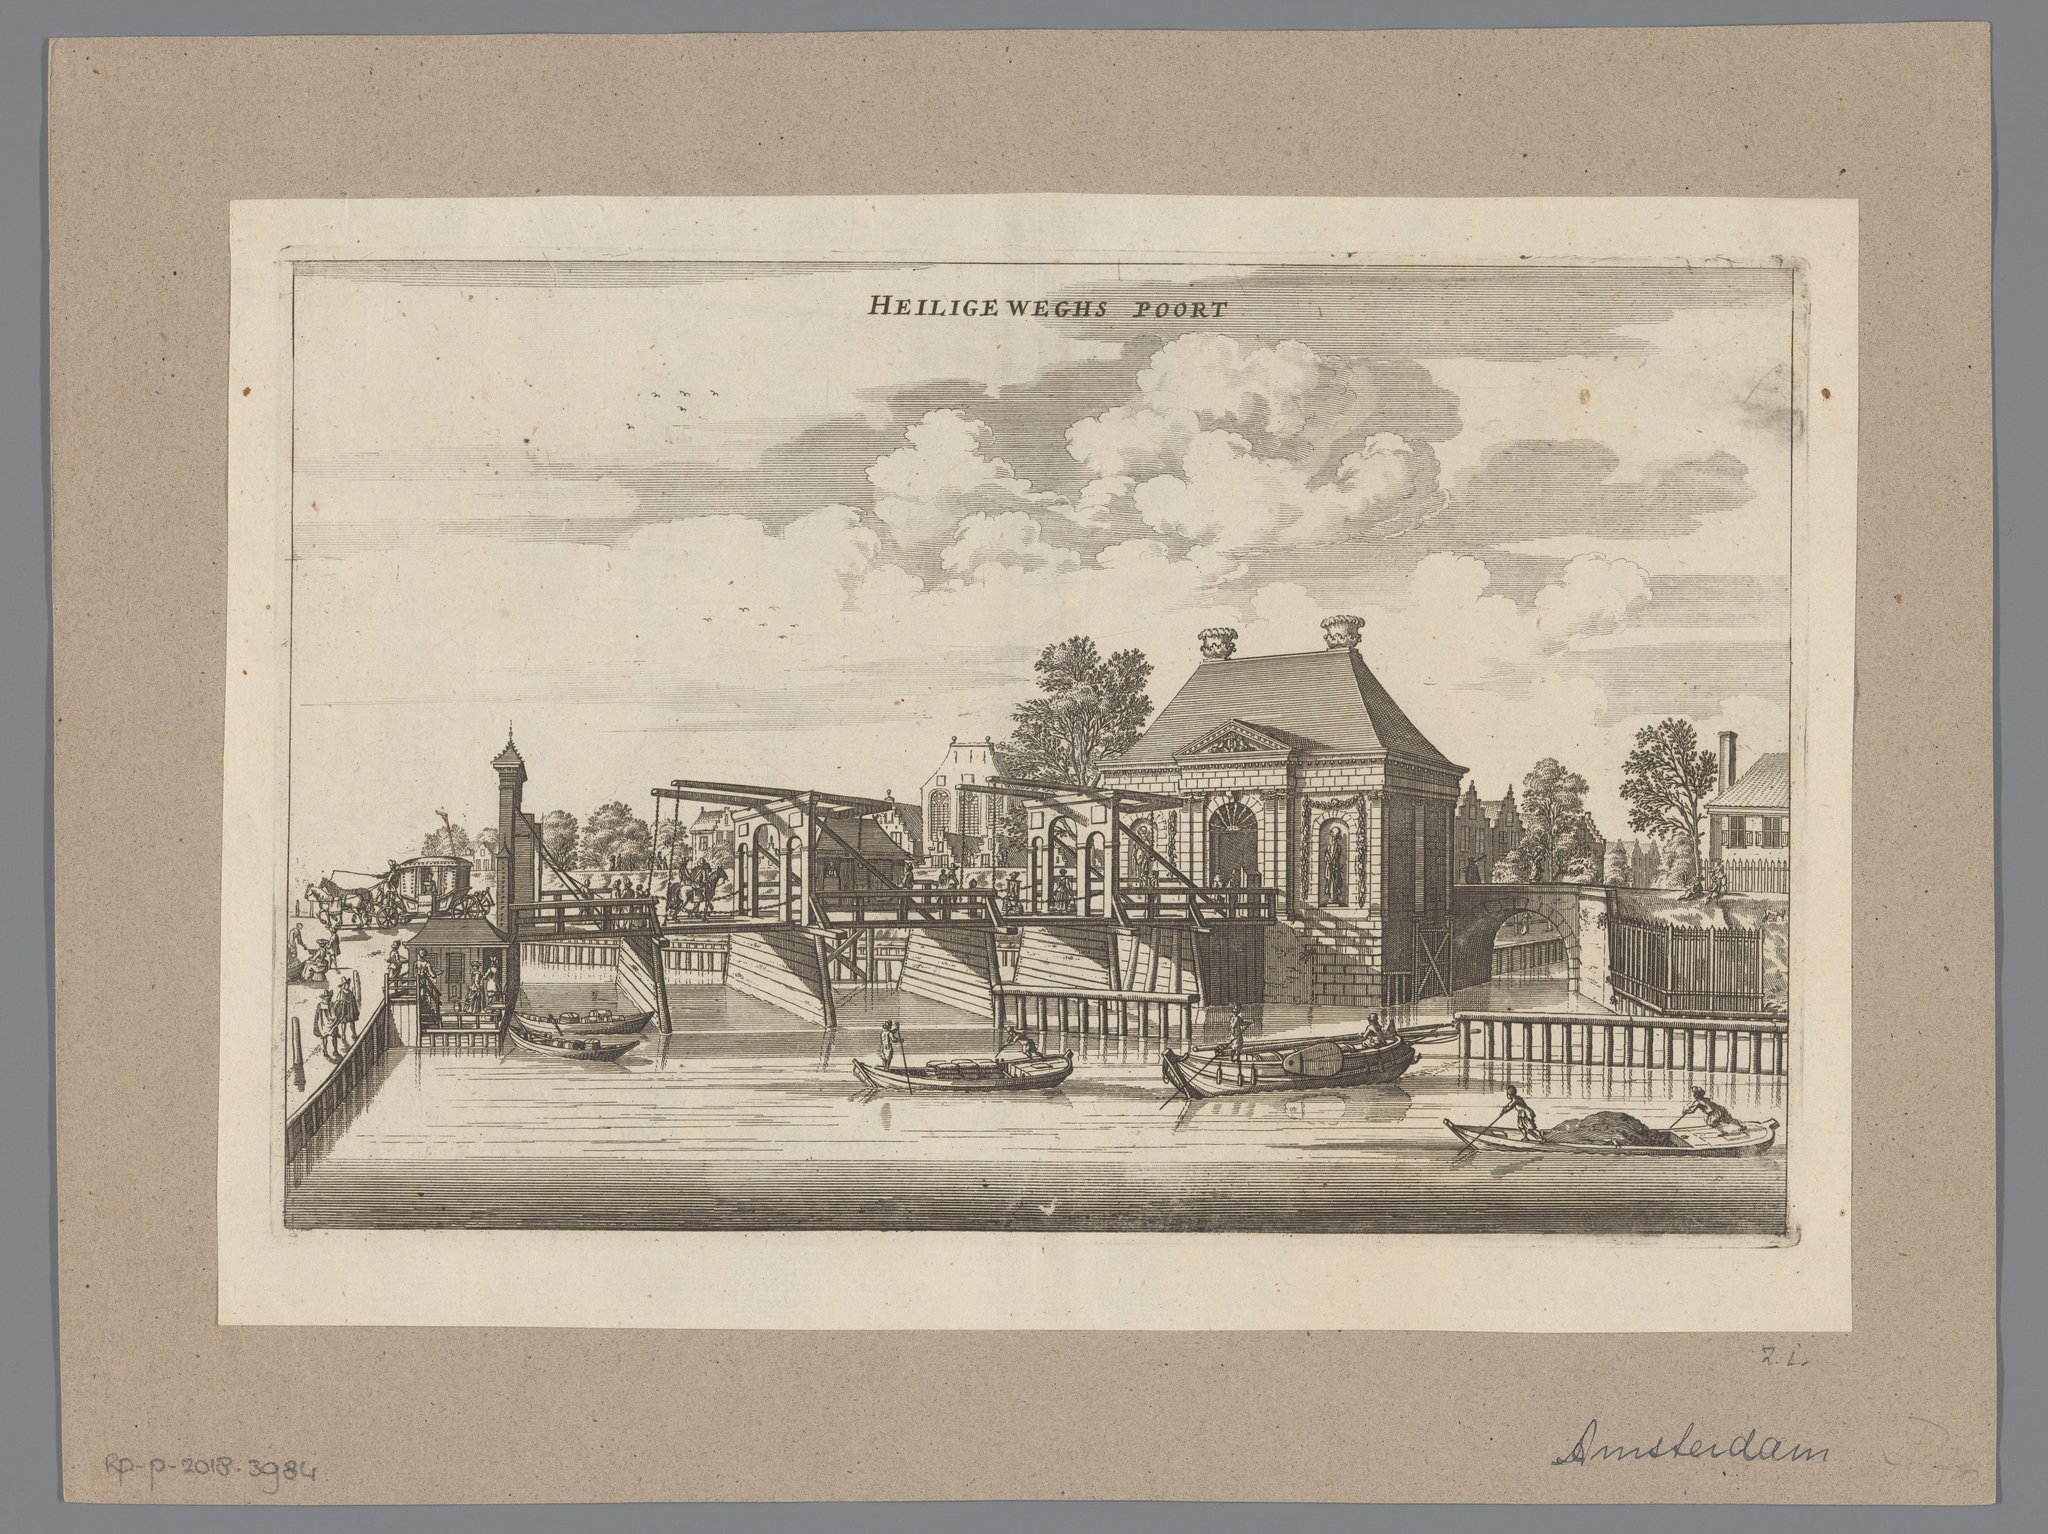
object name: book illustration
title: Heiligeweghs poort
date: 1663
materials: paper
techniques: engraving, etching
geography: amsterdam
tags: rowing-boat, canoe, etc., bridge in city across river, canal, etc., city-gate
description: Prent uit: Dapper, Olfert. Historische beschryving der stadt Amsterdam (...). Amsterdam: Jacob van Meurs, 1663, tussen p. 450-451. Een identieke versie van de prent bestaat met een Frans opschrift boven het Nederlandse opschrift.